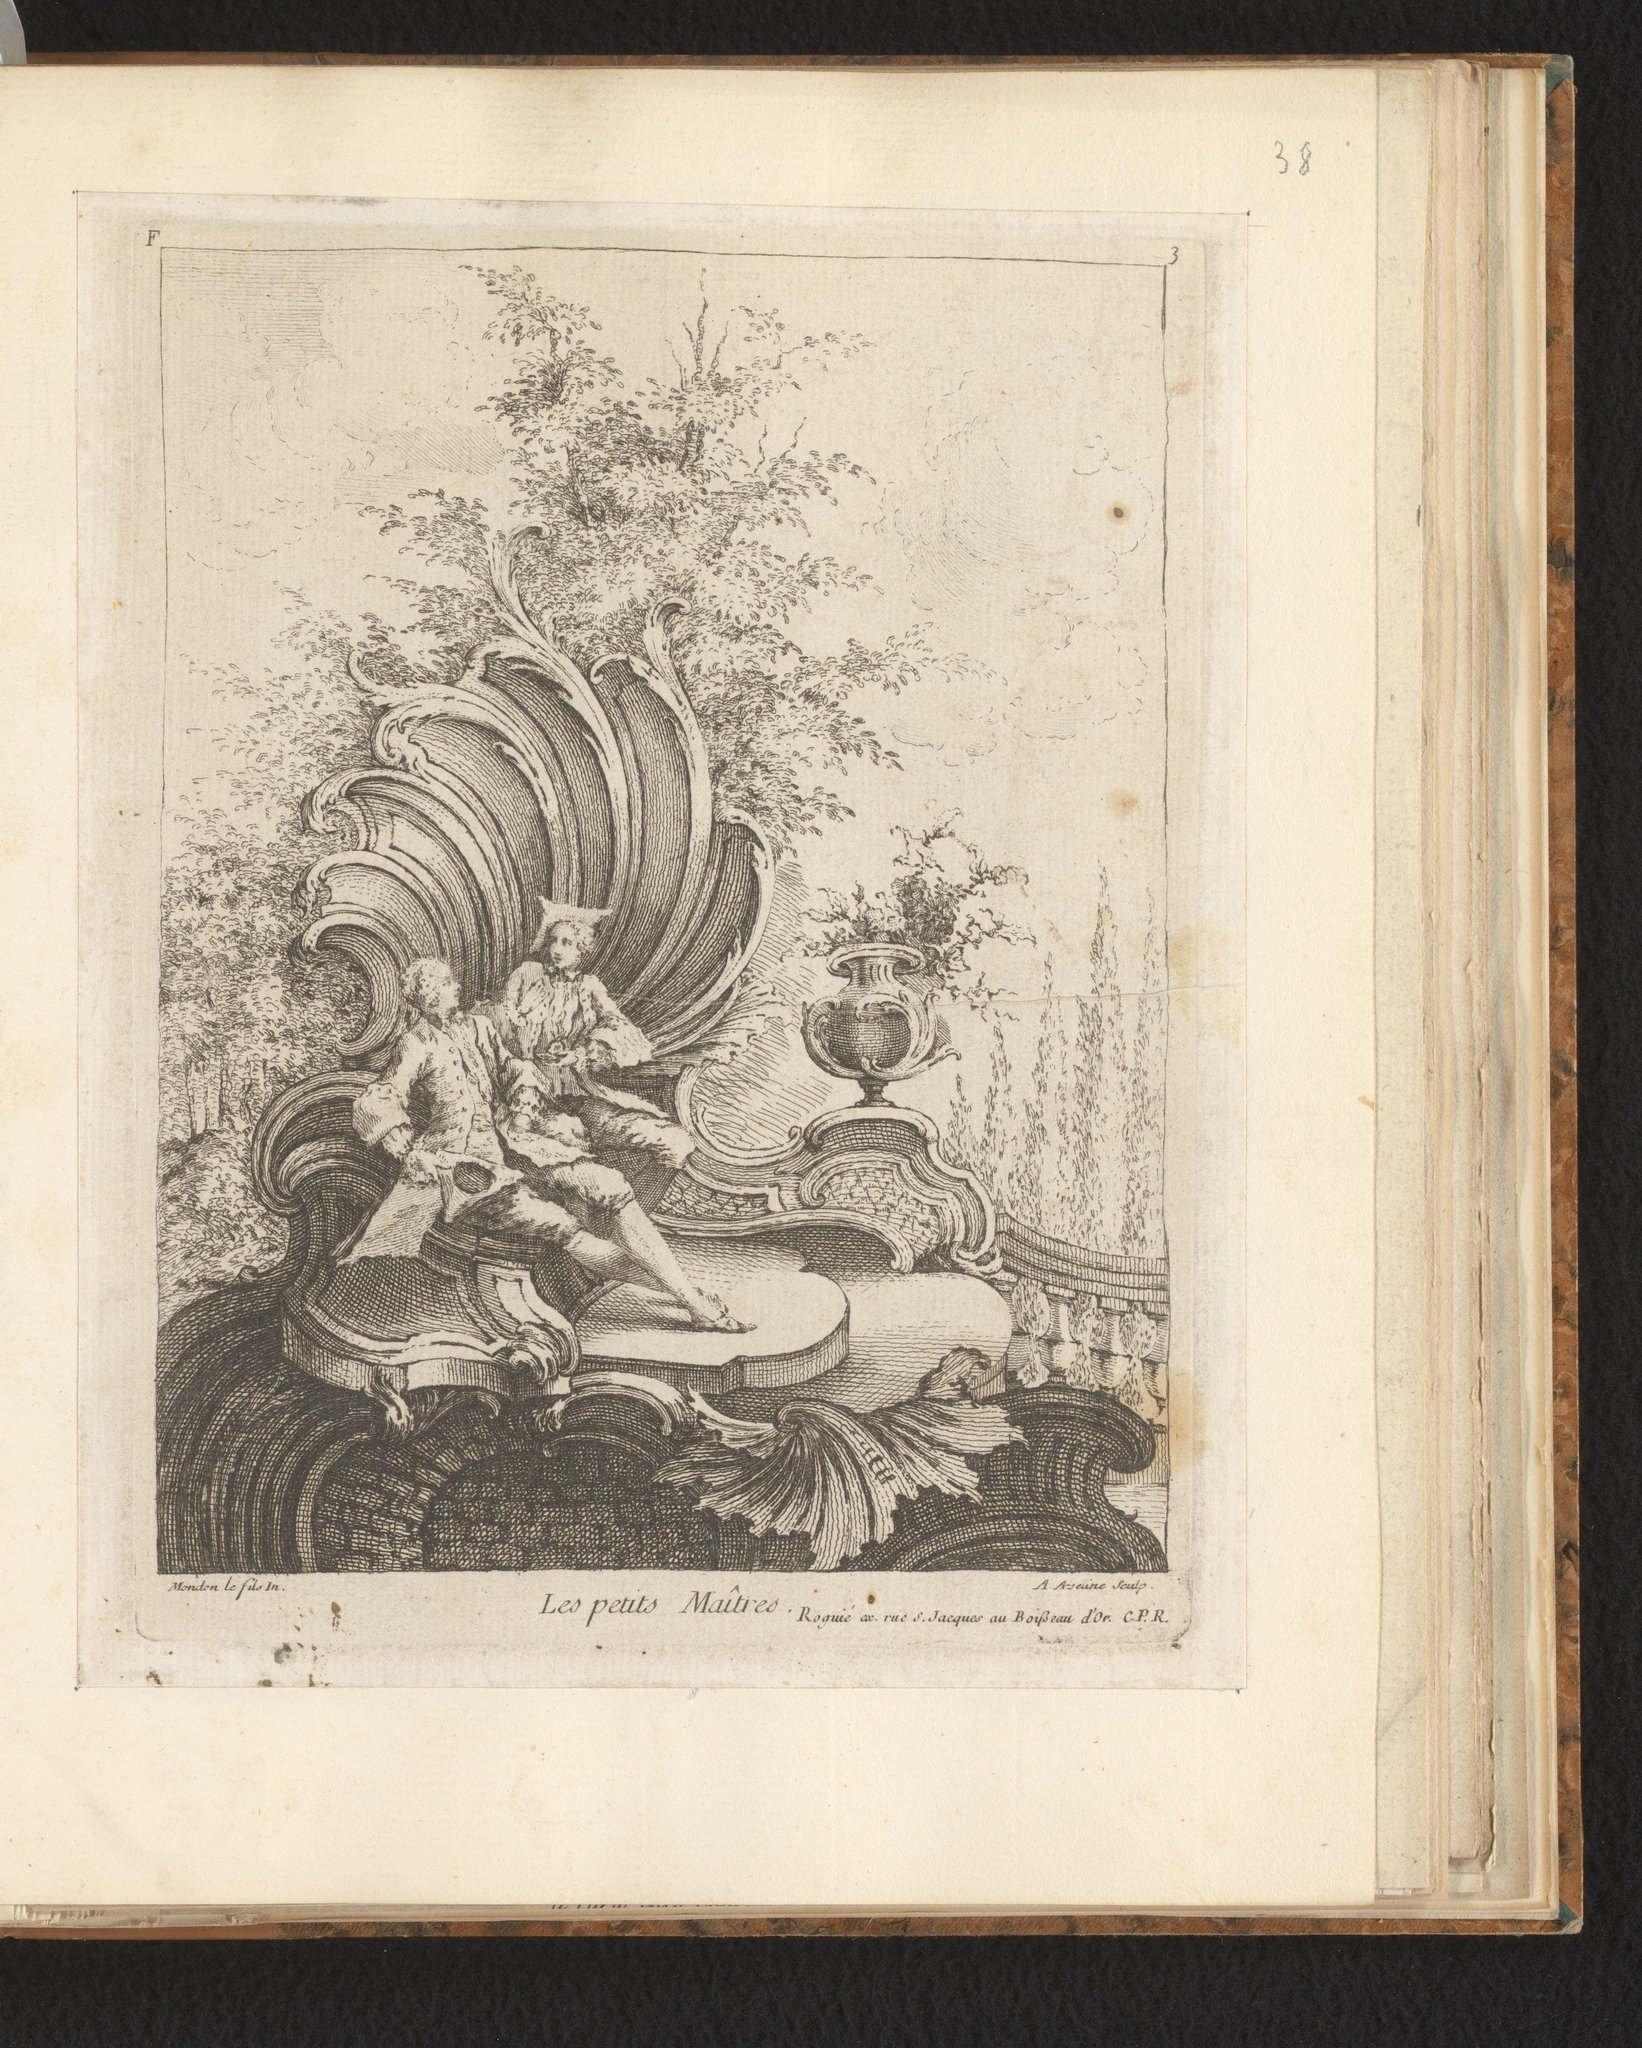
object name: album leaf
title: Rocaille met twee jonge mannen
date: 1736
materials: paper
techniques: etching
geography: paris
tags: rocaille ornament, youth, adolescent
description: Deze serie is linksboven genummerd met een letter F. Prent maakt deel uit van een album.